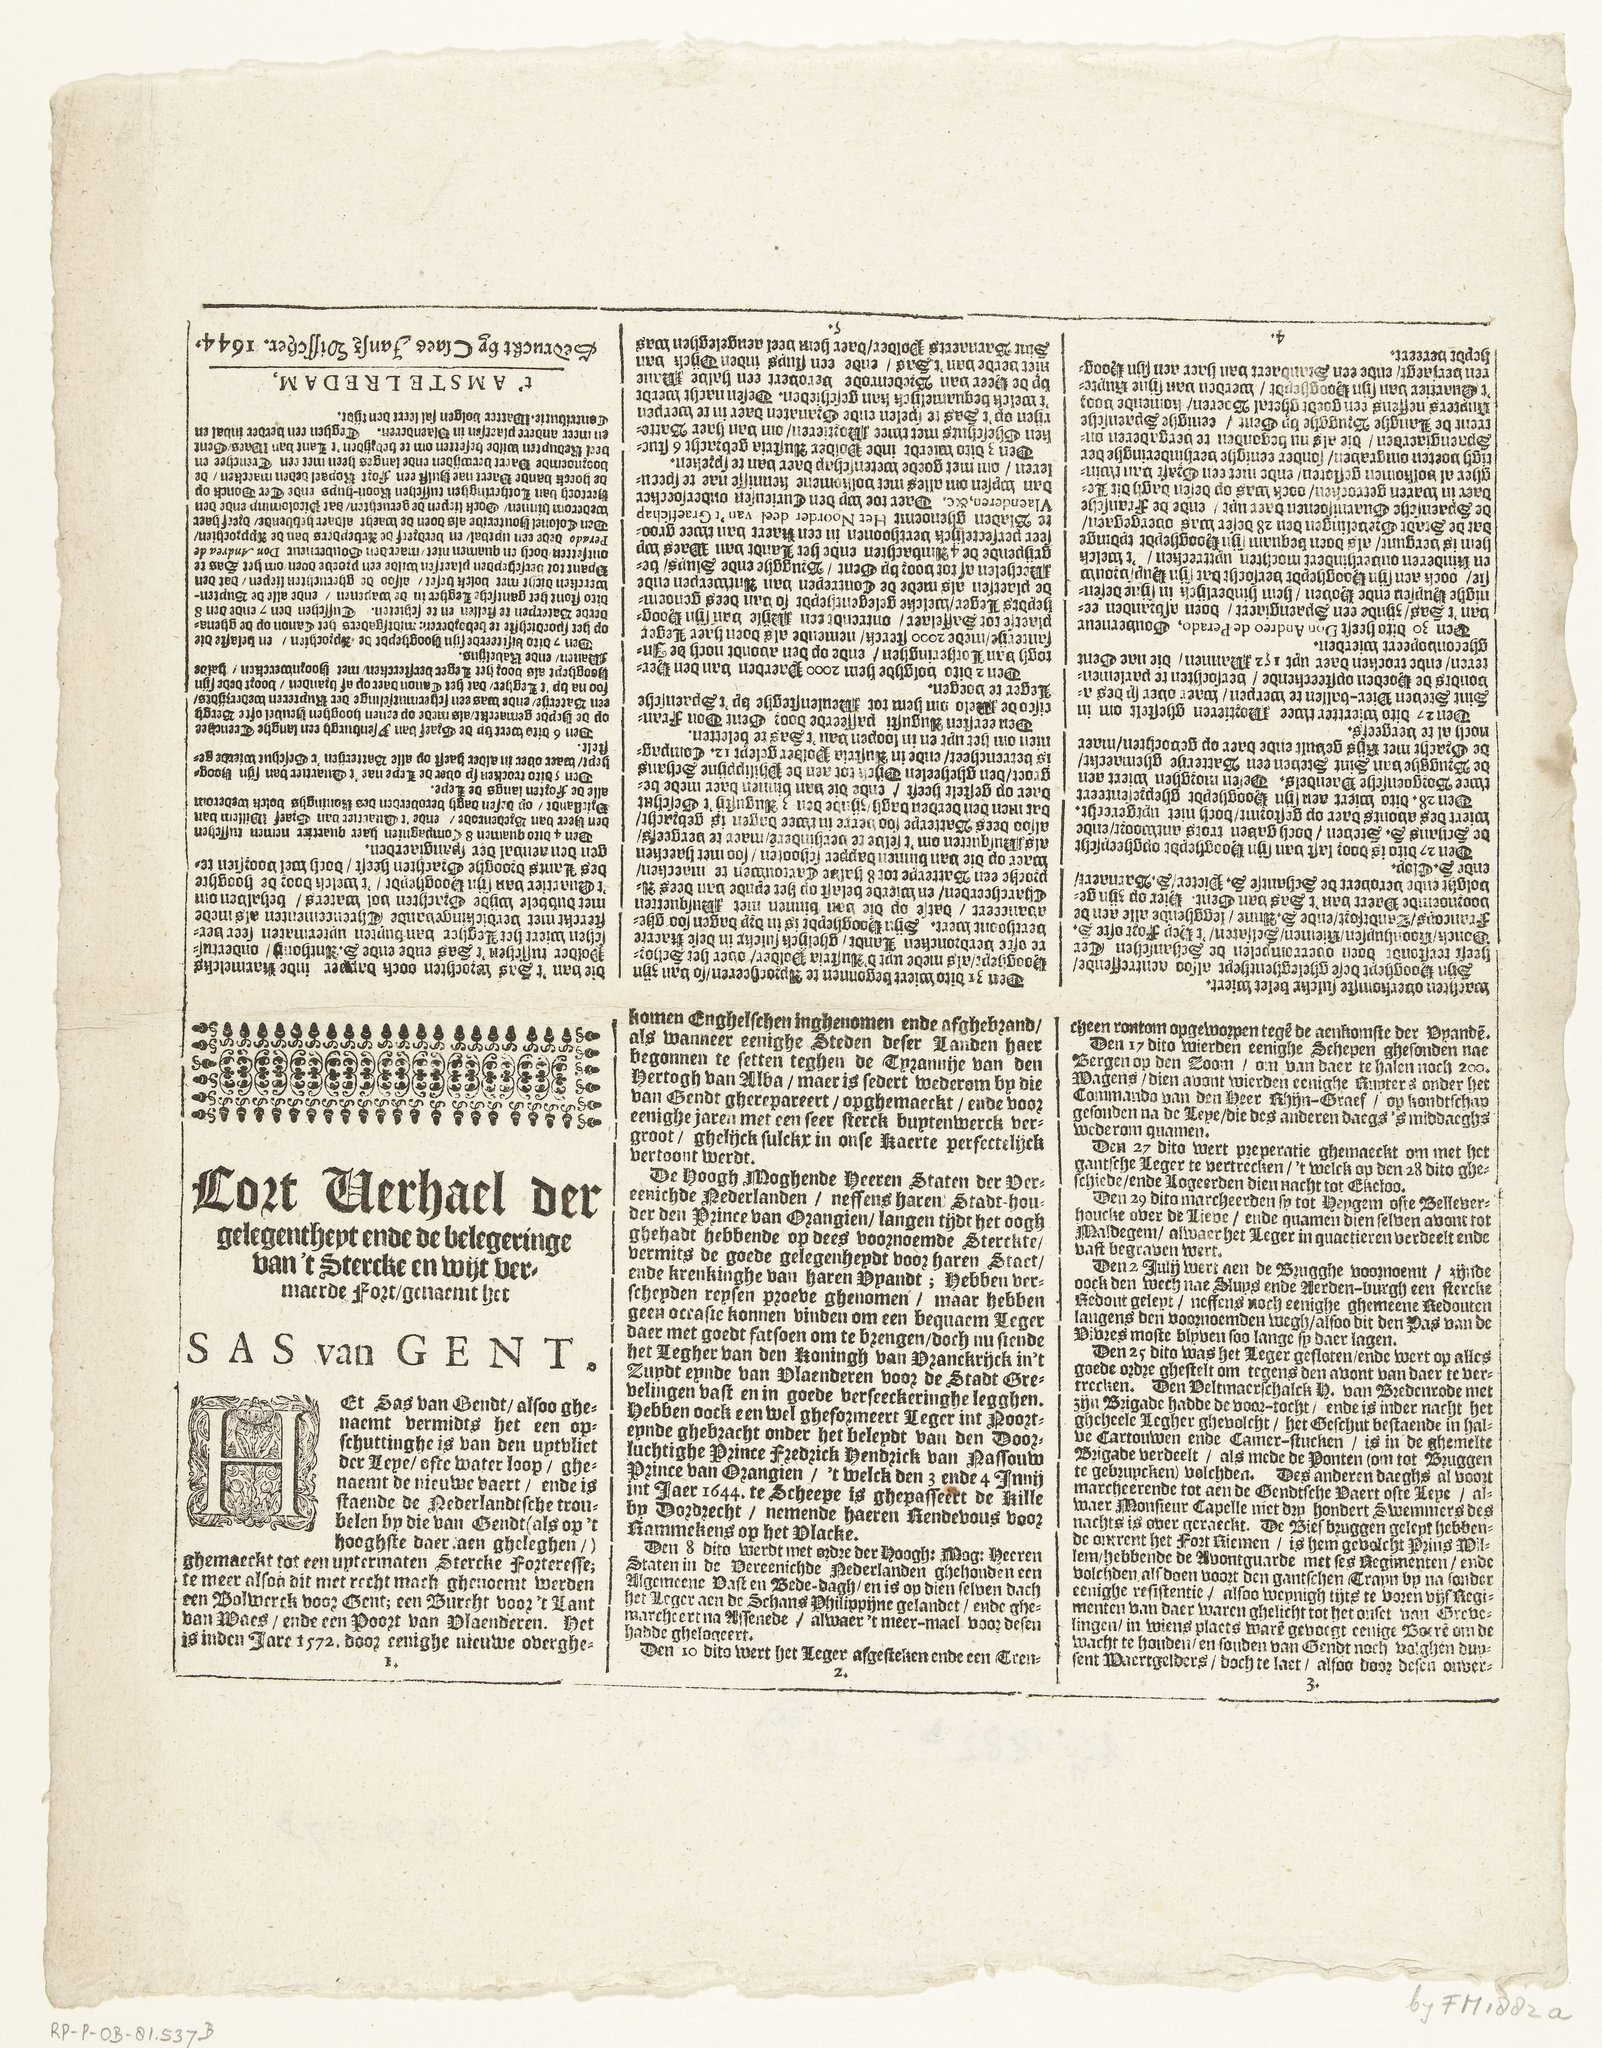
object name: print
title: Cort Verhael der gelegentheyt ende de belegeringe van 't Stercke en wijt vermaerde Fort / genaemt het Sas van Gent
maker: claes jansz. visscher (ii)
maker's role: draughtsman, print maker, publisher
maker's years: 1586-1652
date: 1644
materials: paper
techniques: letterpress printing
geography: amsterdam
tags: delft, the hague, frederick henry (prince of orange), maps of separate countries or regions, siege, position war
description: Tekstblad bij de prent met de kaart van het beleg van de stad Sas-van Gent door het Staatse leger onder Frederik Hendrik, begonnen 28 juli 1644. Tekst in 6 genummerde kolommen (in 2 delen gedraaid boven elkaar gedrukt) in het Nederlands (met laatst vermelde datum 8 augustus).